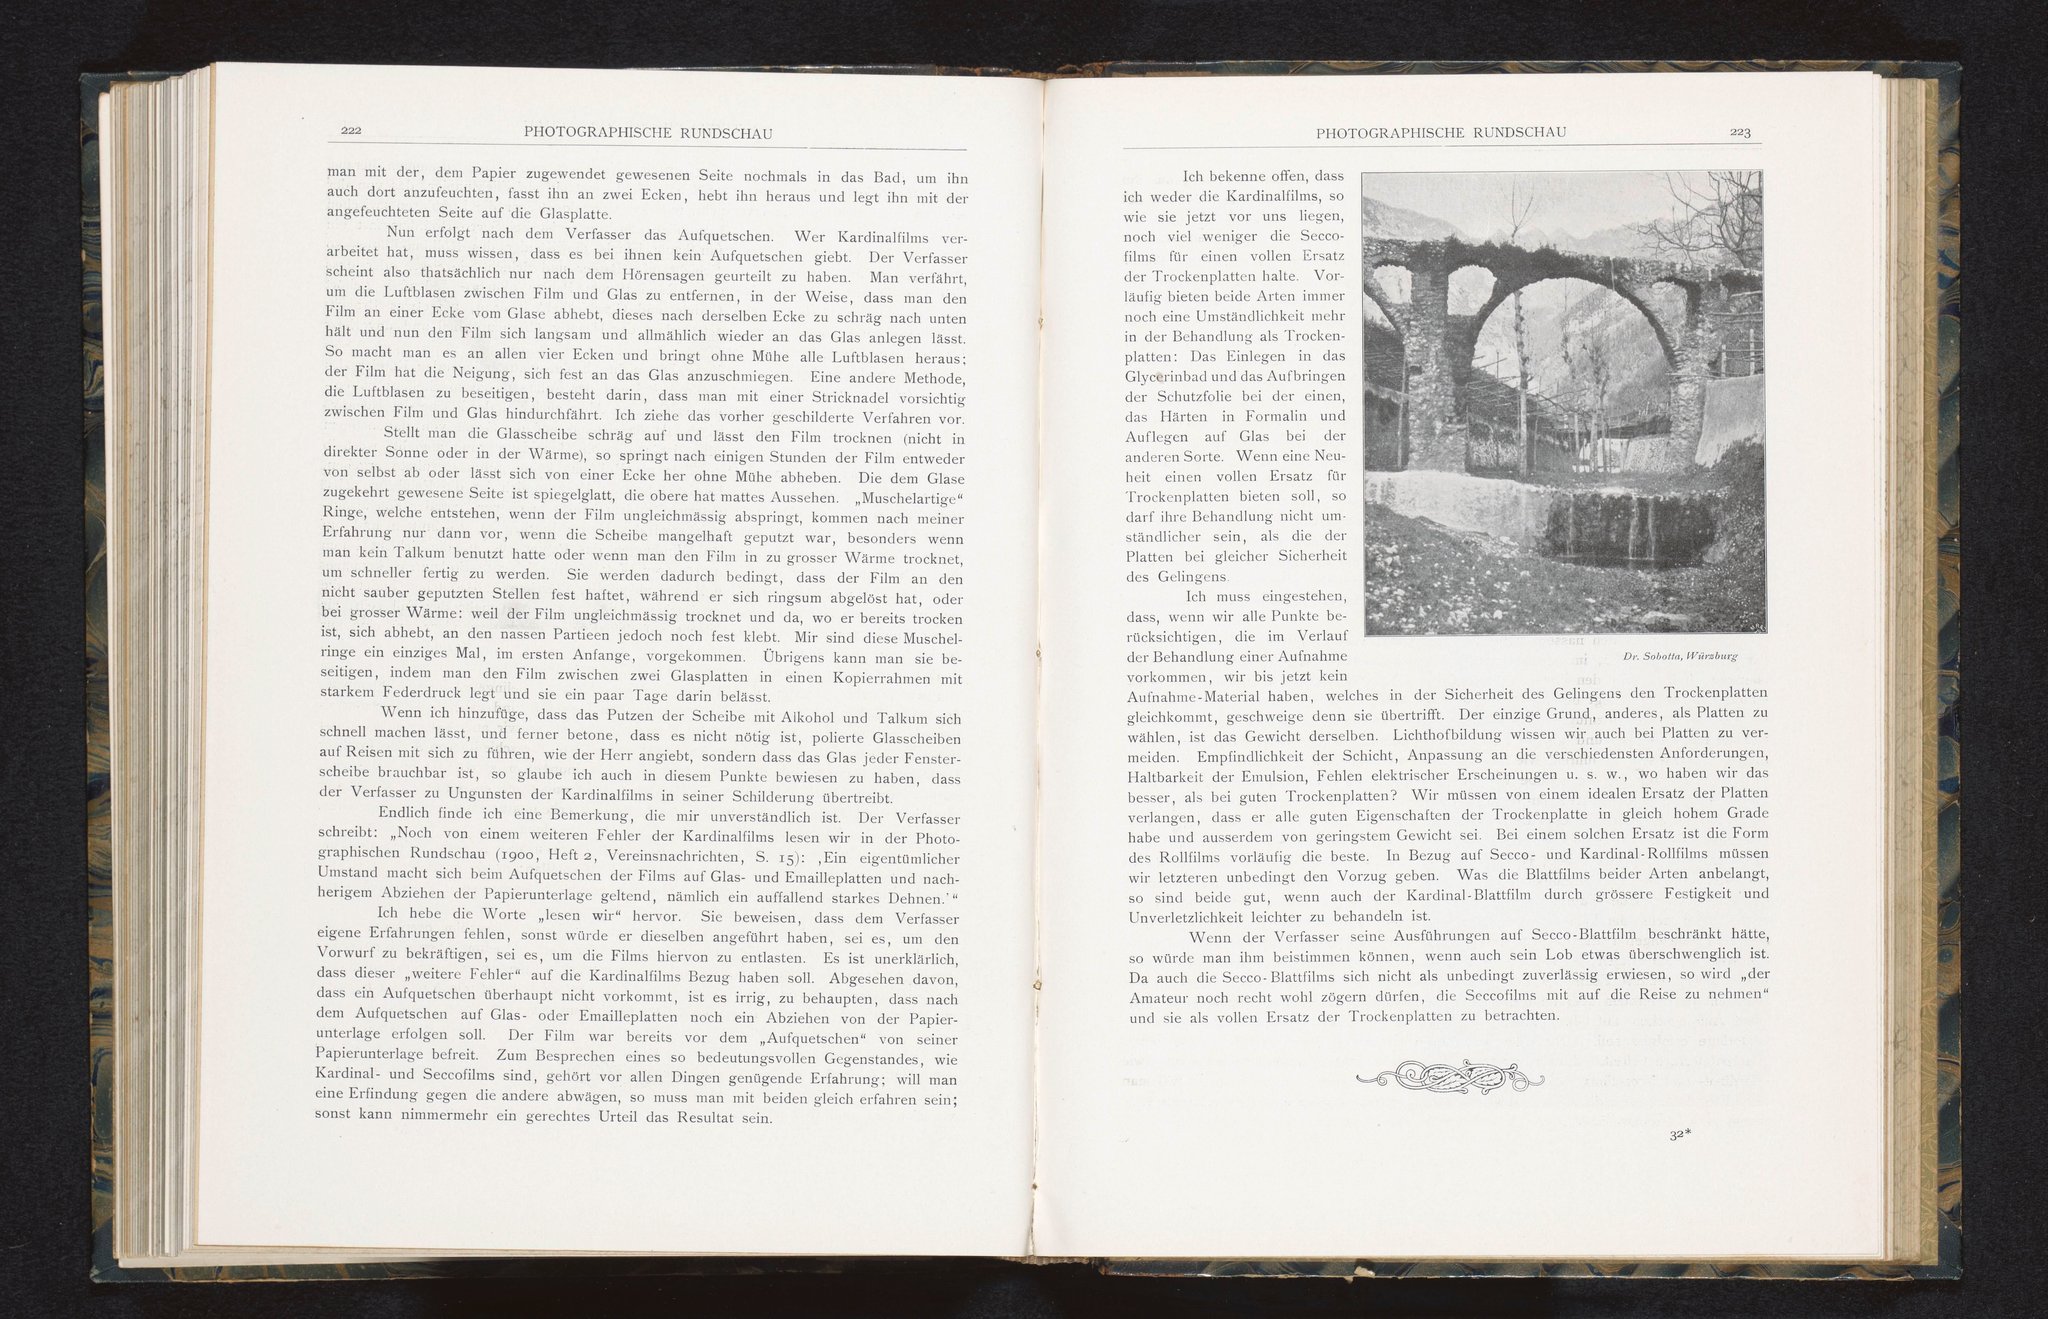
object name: page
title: Gezicht op een viaduct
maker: dr. sobotta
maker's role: fotograaf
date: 1895-1900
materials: paper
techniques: autotype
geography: berlin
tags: viaduct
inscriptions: monogram: ‘MR&C’